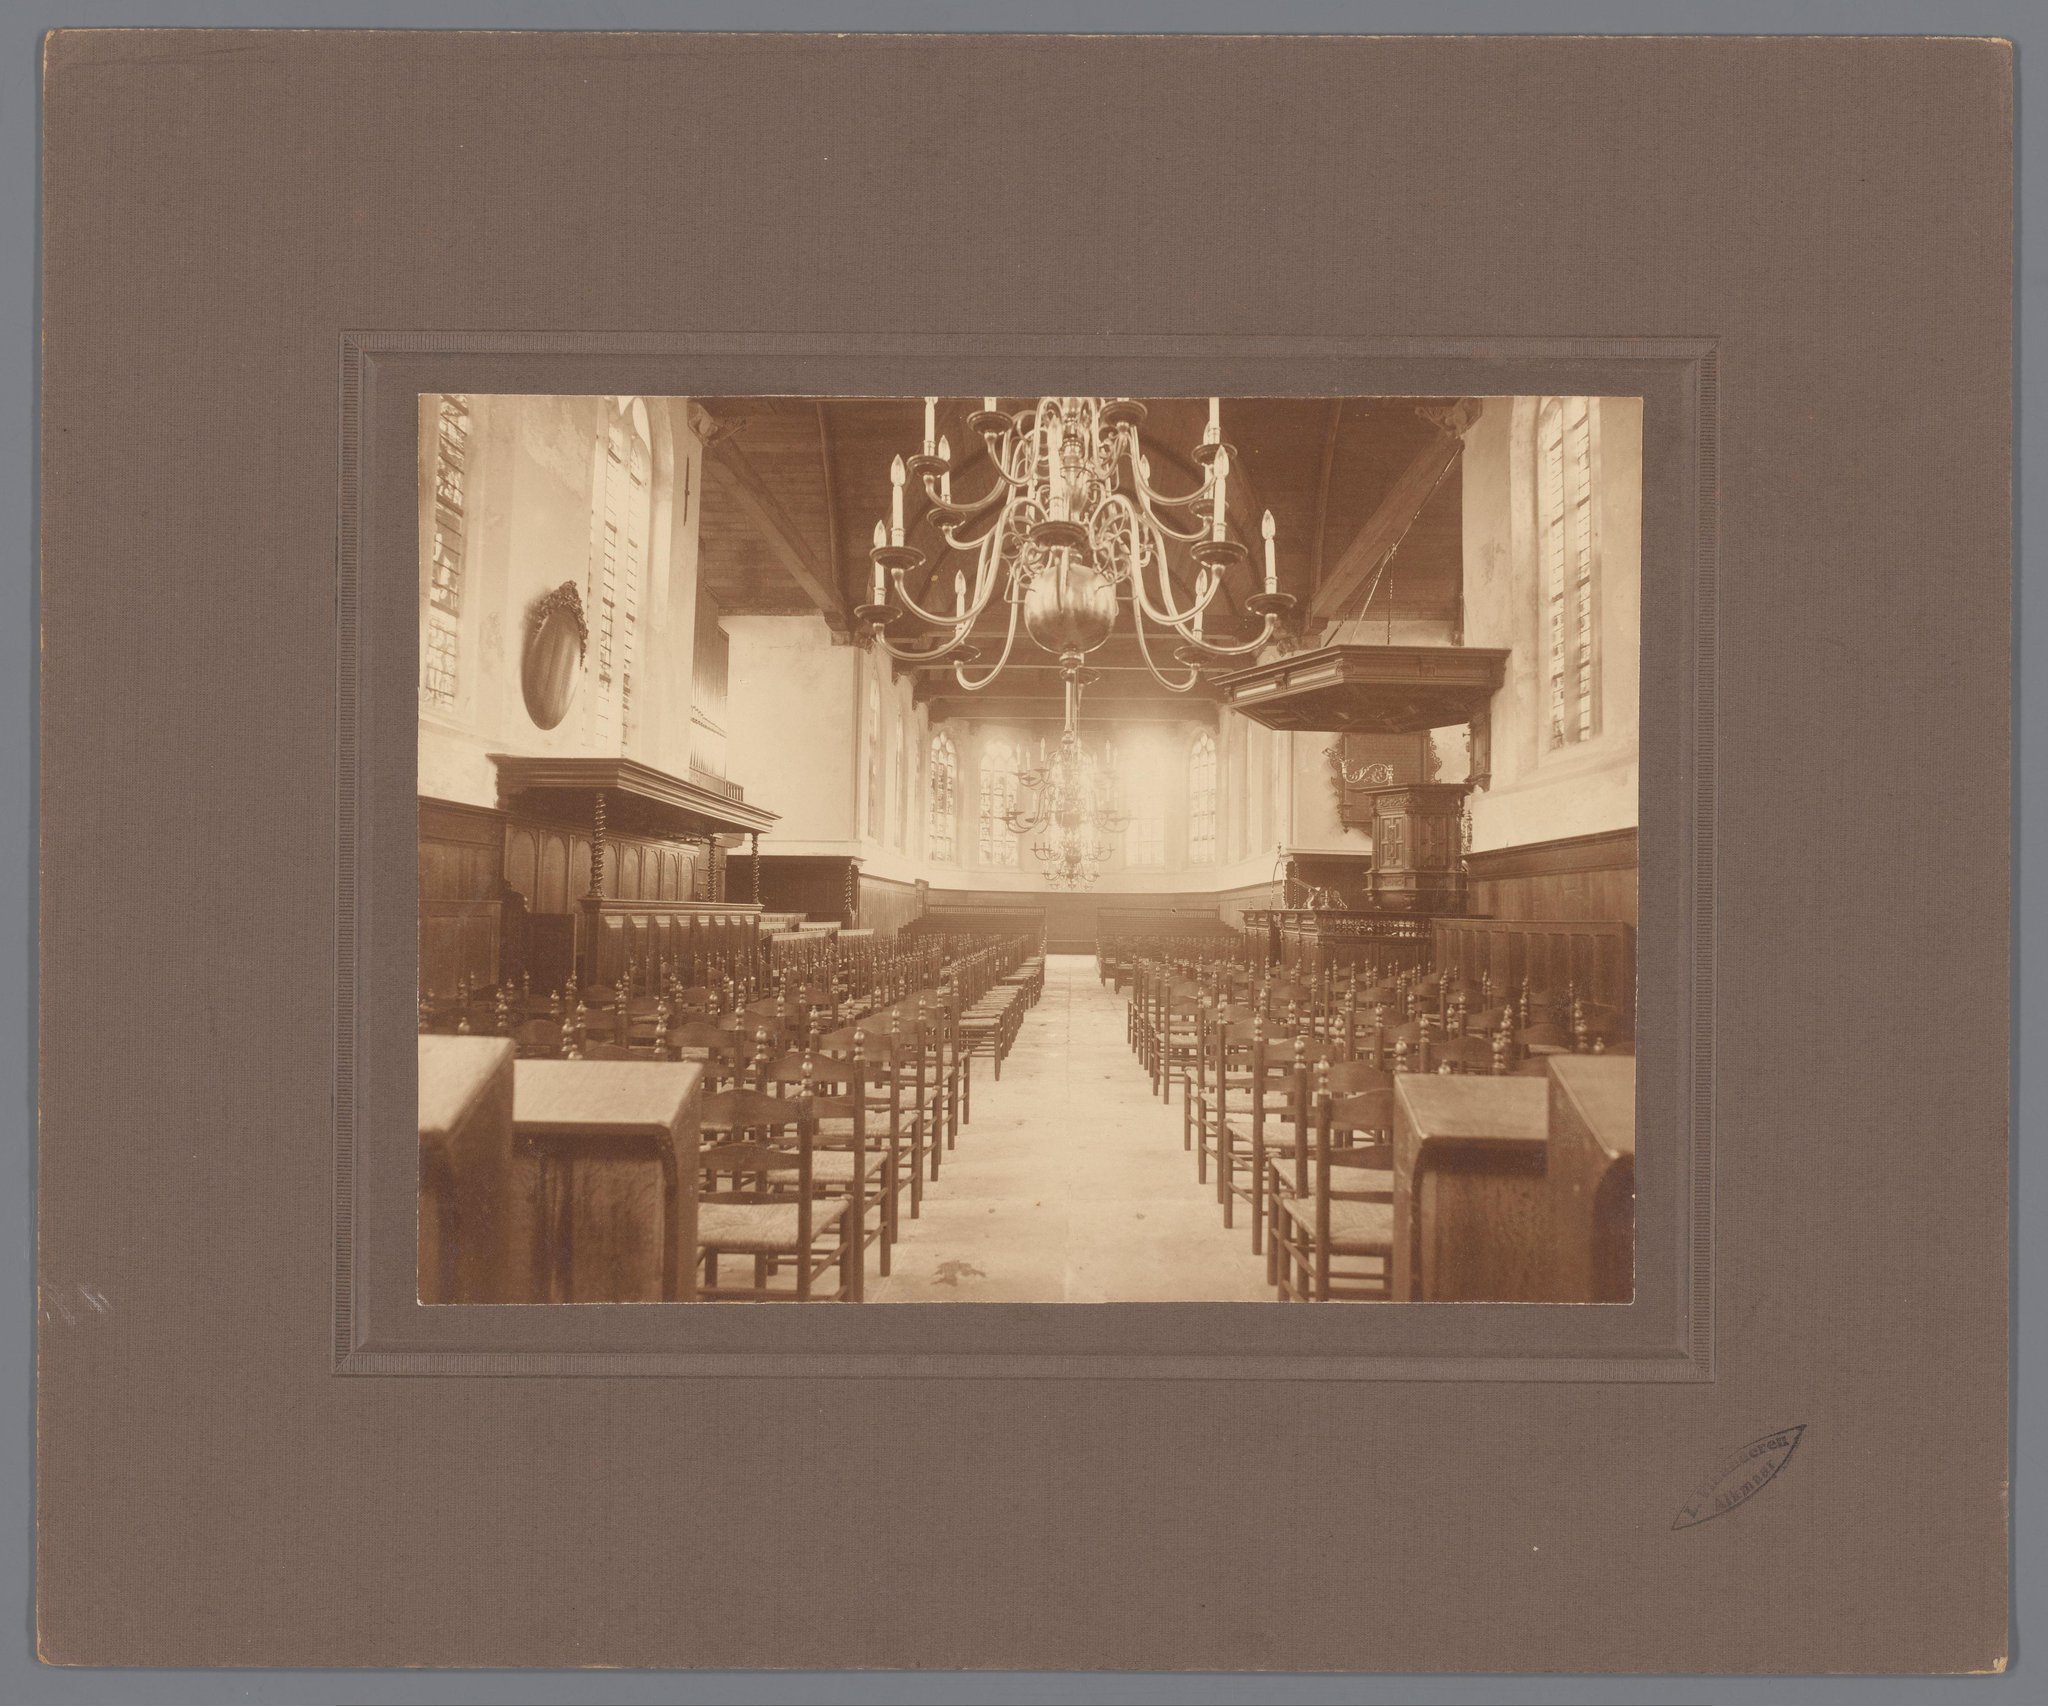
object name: photograph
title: Interieur van de Nederlands Hervormde Kerk in De Rijp, Noord-Holland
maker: leonard vlaanderen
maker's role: fotograaf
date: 1923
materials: cardboard, photographic support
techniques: gelatin silver print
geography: alkmaar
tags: de rijp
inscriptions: annotation: ‘De Rijp 1923’, stamp: ‘L.Vlaanderen//Alkmaar’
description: Interieur van de Nederlands Hervormde Kerk in De Rijp, Noord-Holland. Houten plafond, twee grote kroonluchters en stoelen.